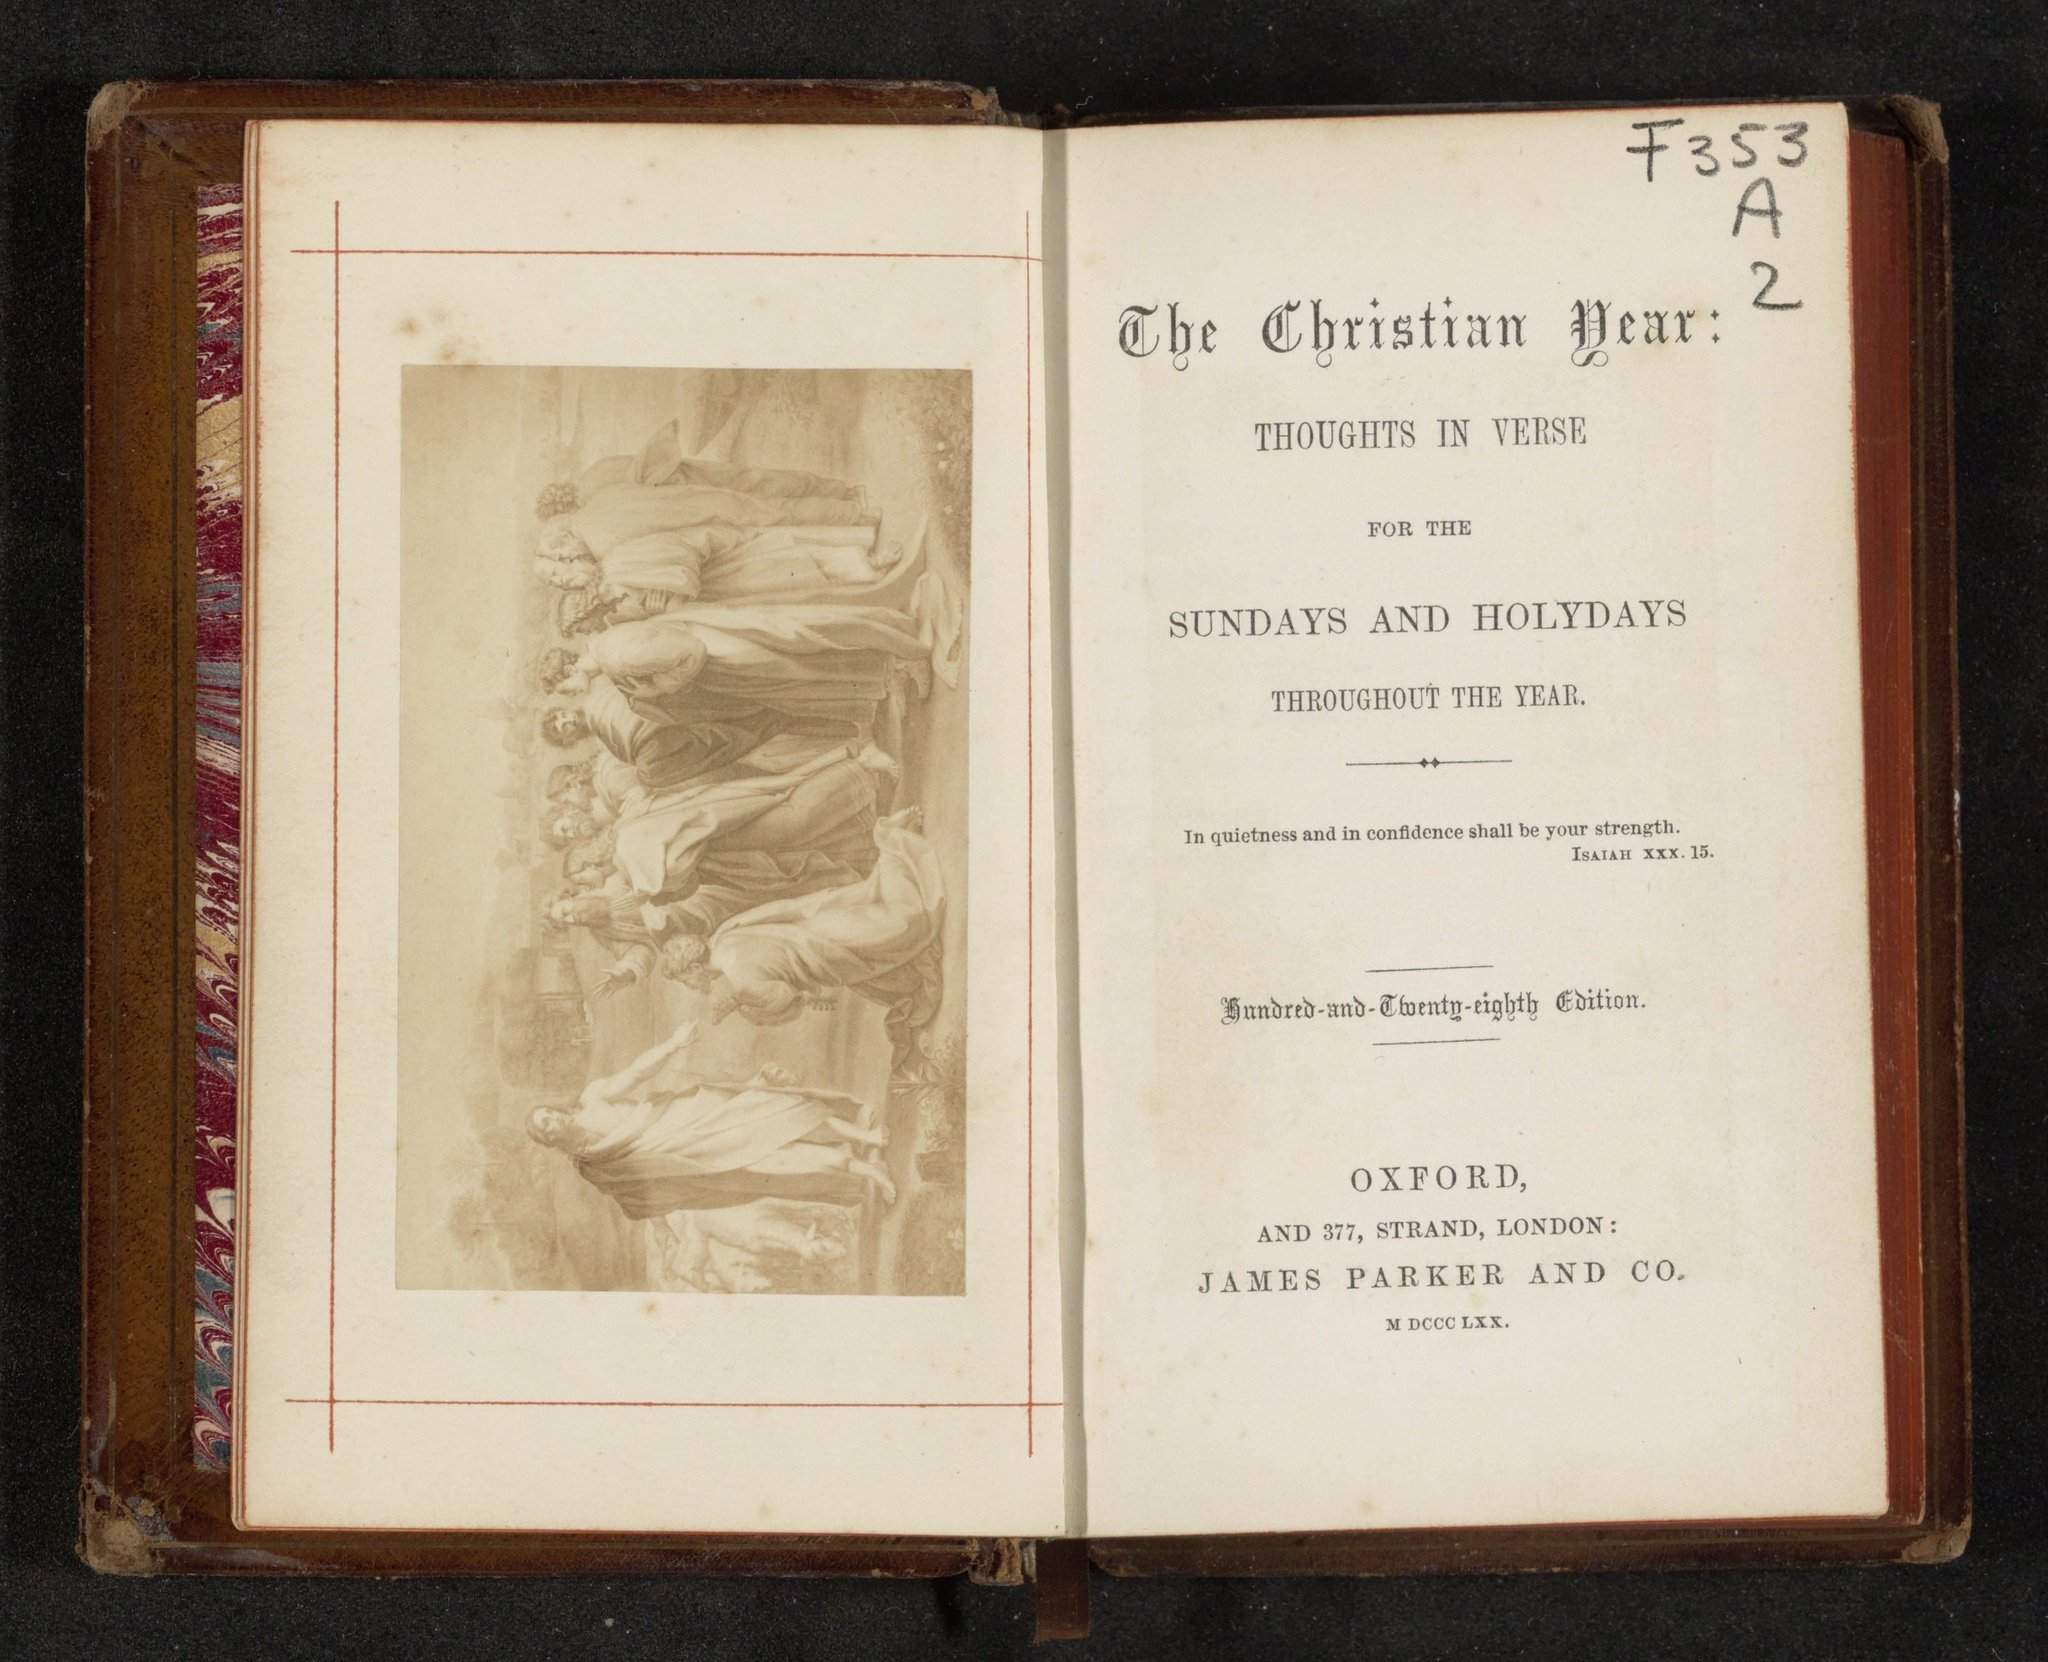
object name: reproduction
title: Fotoreproductie van een schilderij, voorstellende Christus wijst Petrus een kudde schapen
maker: Anonymous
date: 1865-1870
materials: photographic support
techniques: albumen print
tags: mission of peter ('pasce oves meas'): christ pointing to a lamb, peter perhaps with keys in his hands